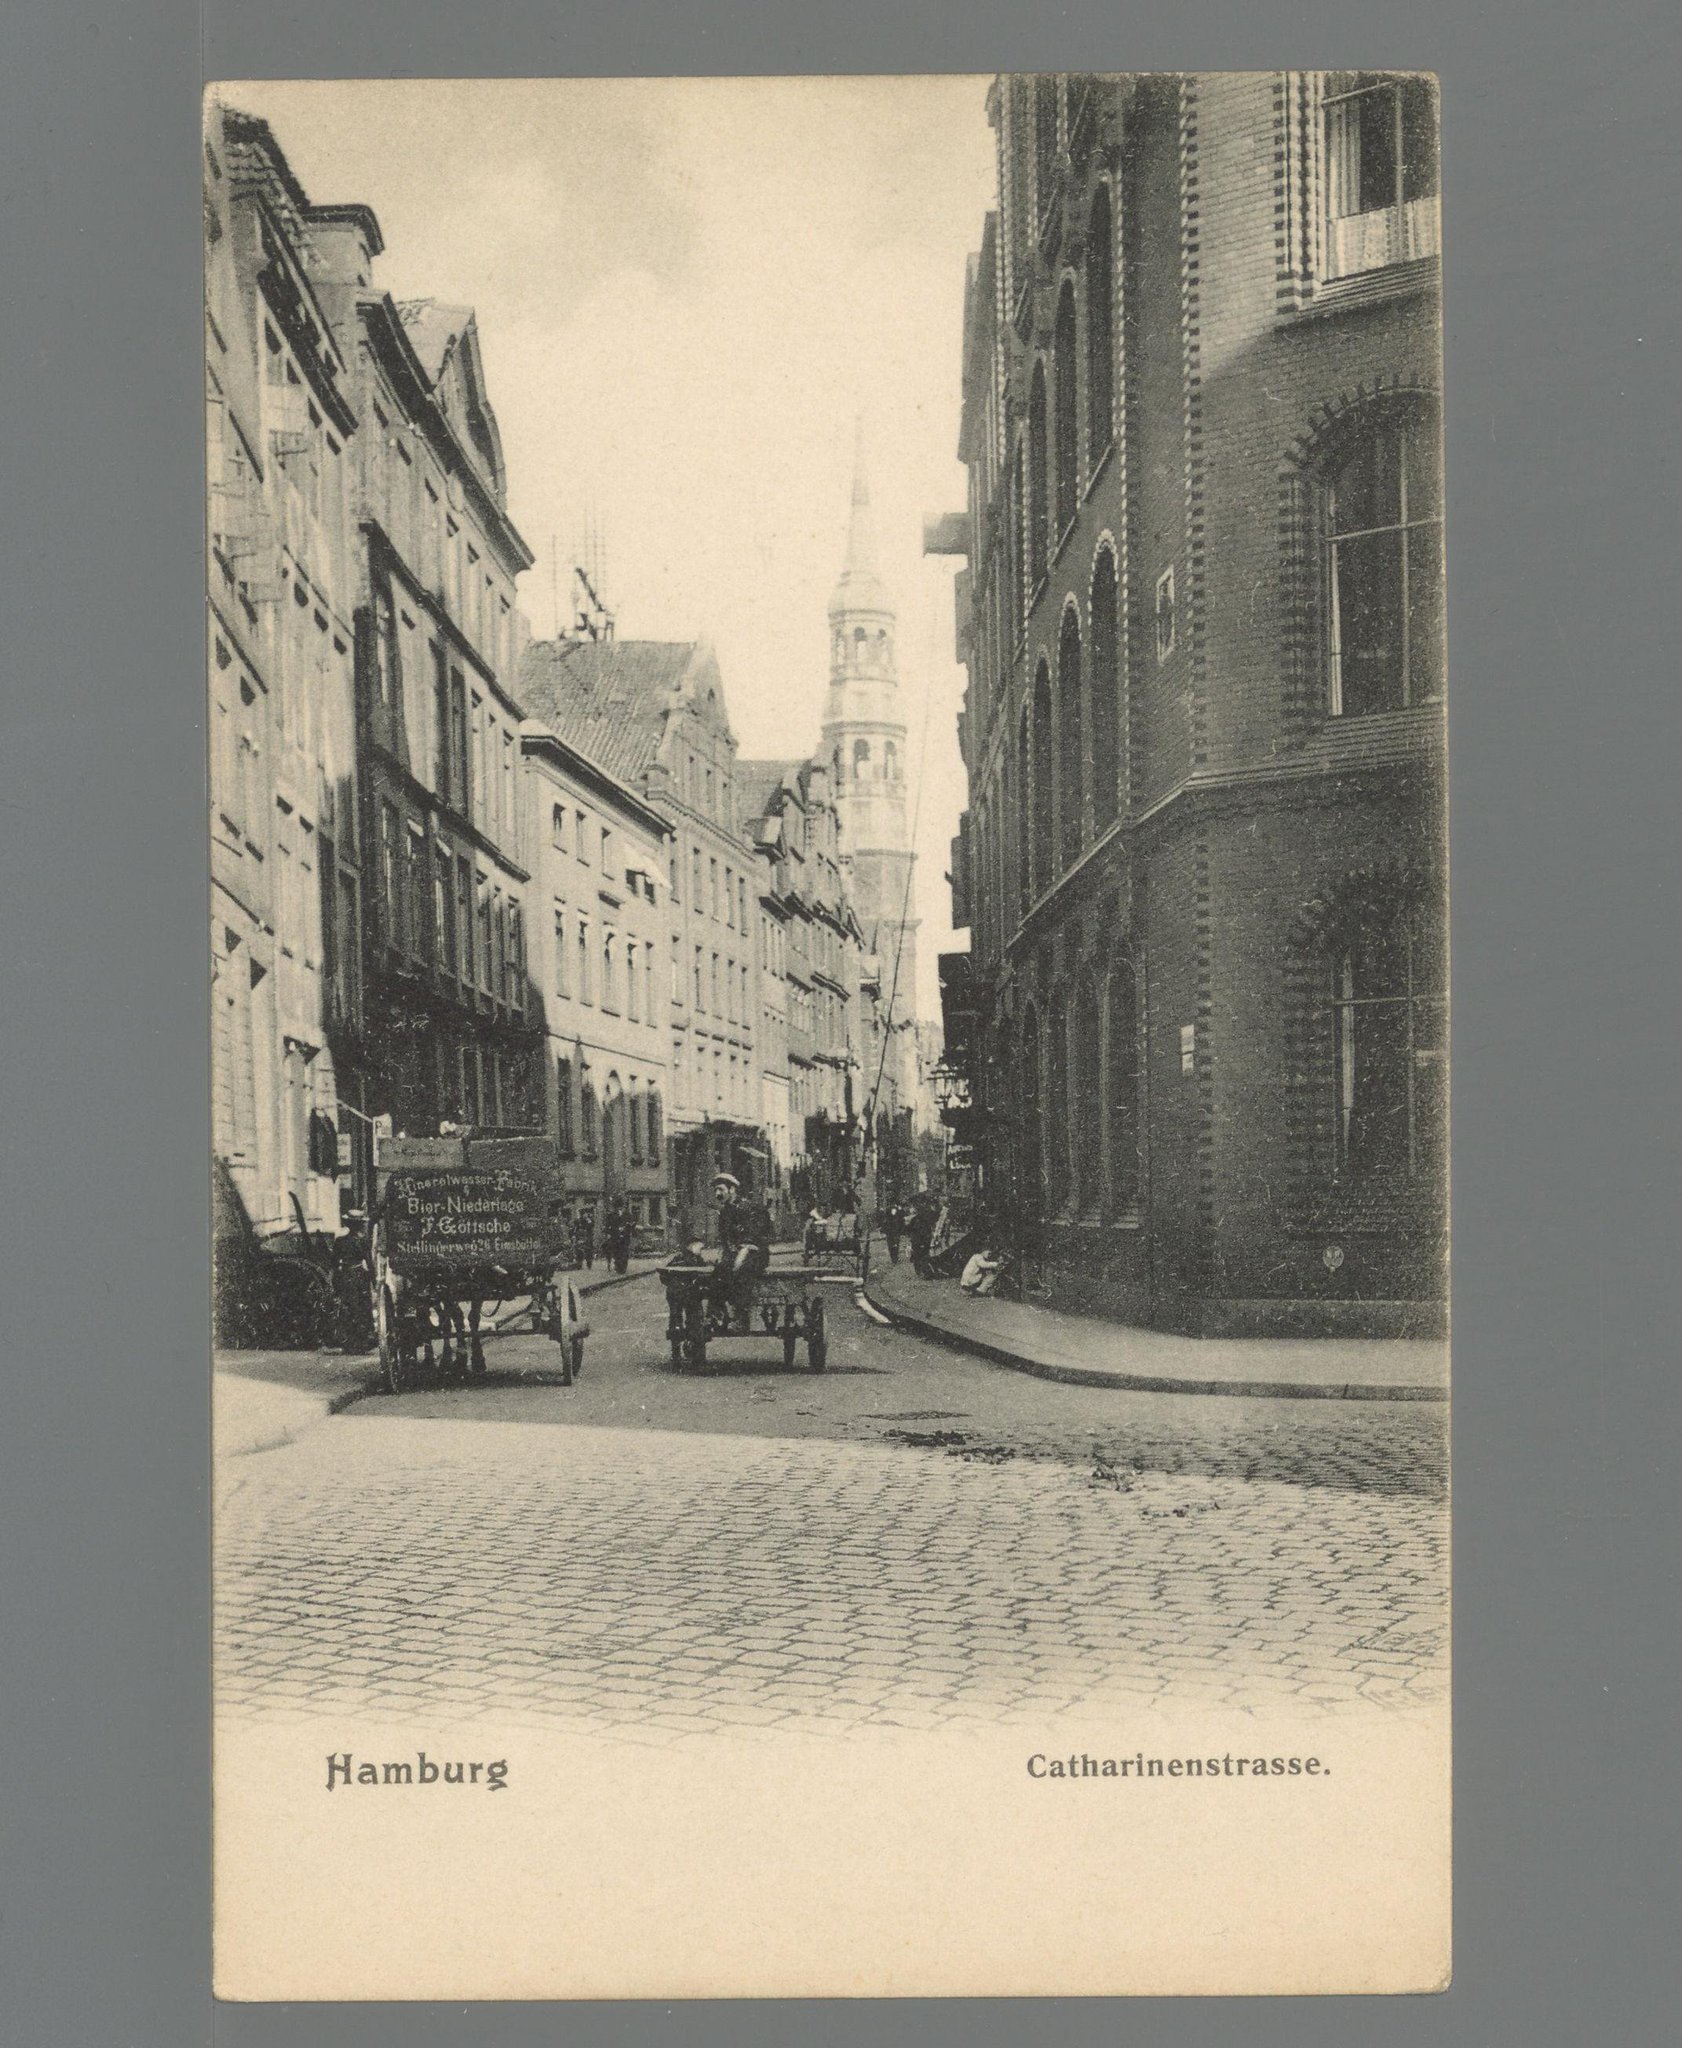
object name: photomechanical print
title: Hamburg. Catharinenstrasse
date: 1904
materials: cardboard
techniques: photograph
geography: hamburg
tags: church (exterior), street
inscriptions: date